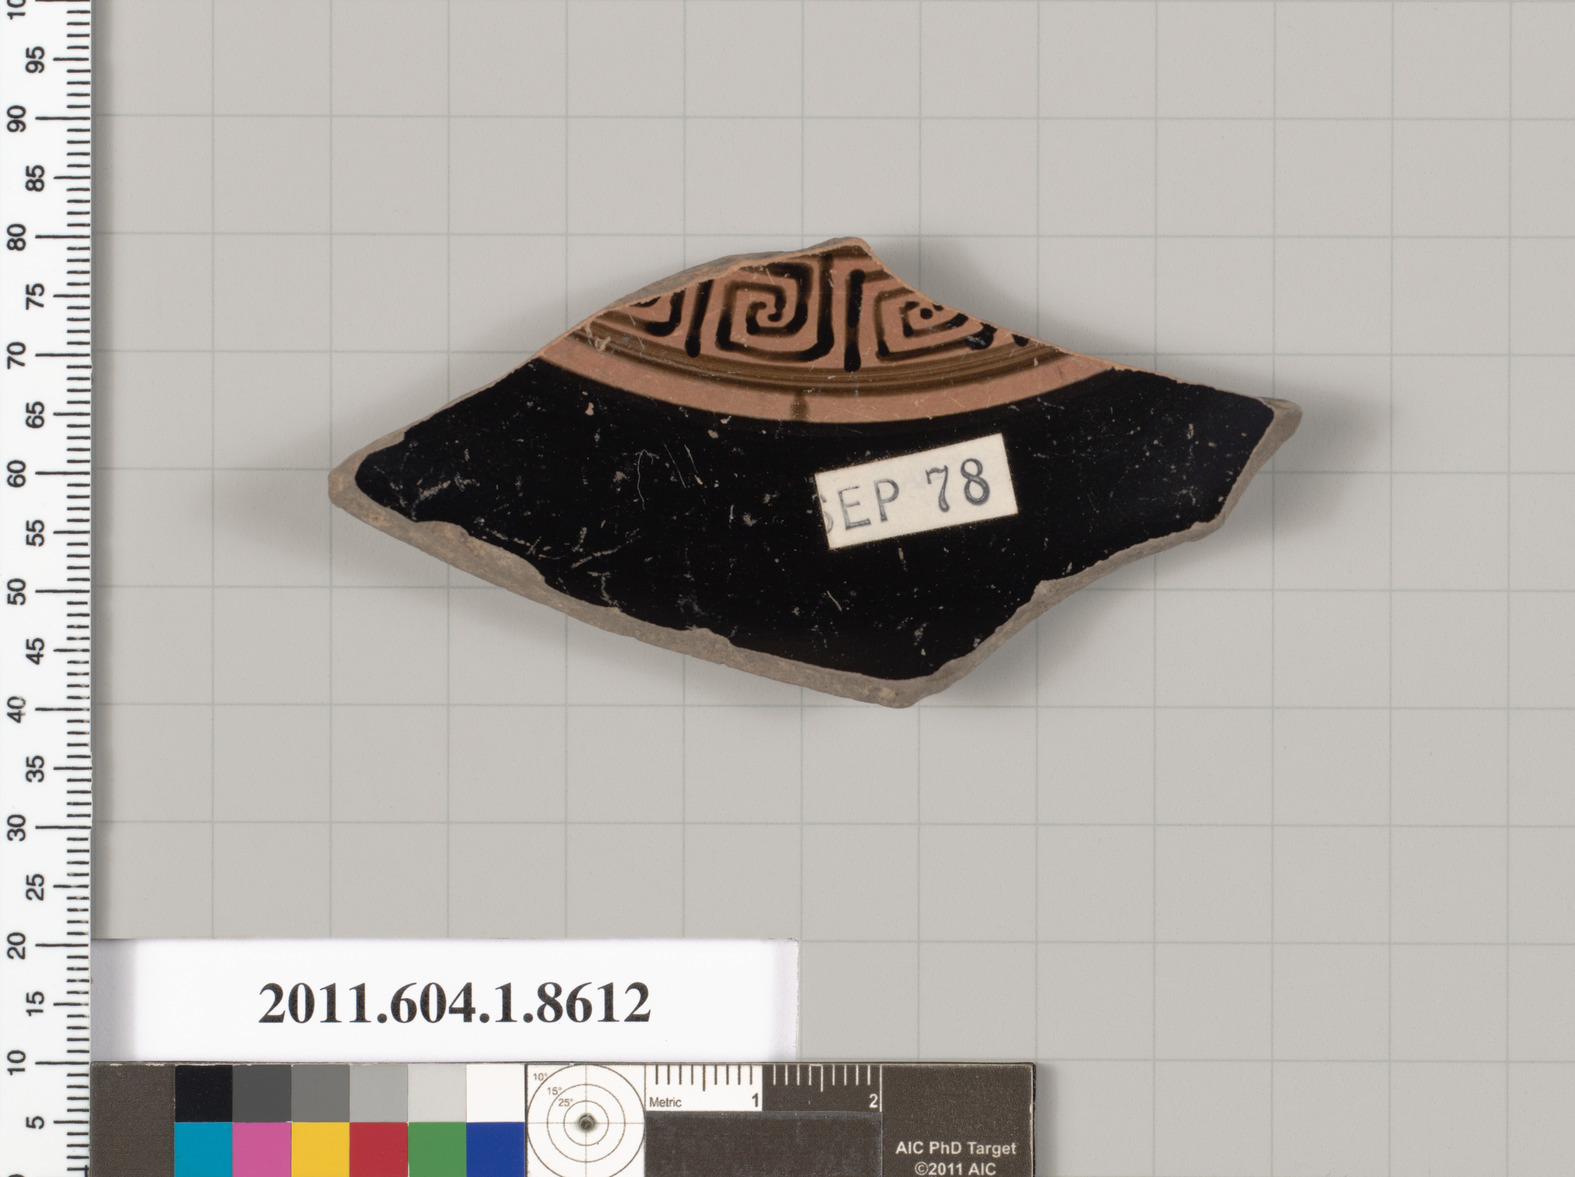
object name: kylix fragment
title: Terracotta fragment of a stemless kylix (drinking cup)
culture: greek, attic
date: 460-450 BCE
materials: terracotta